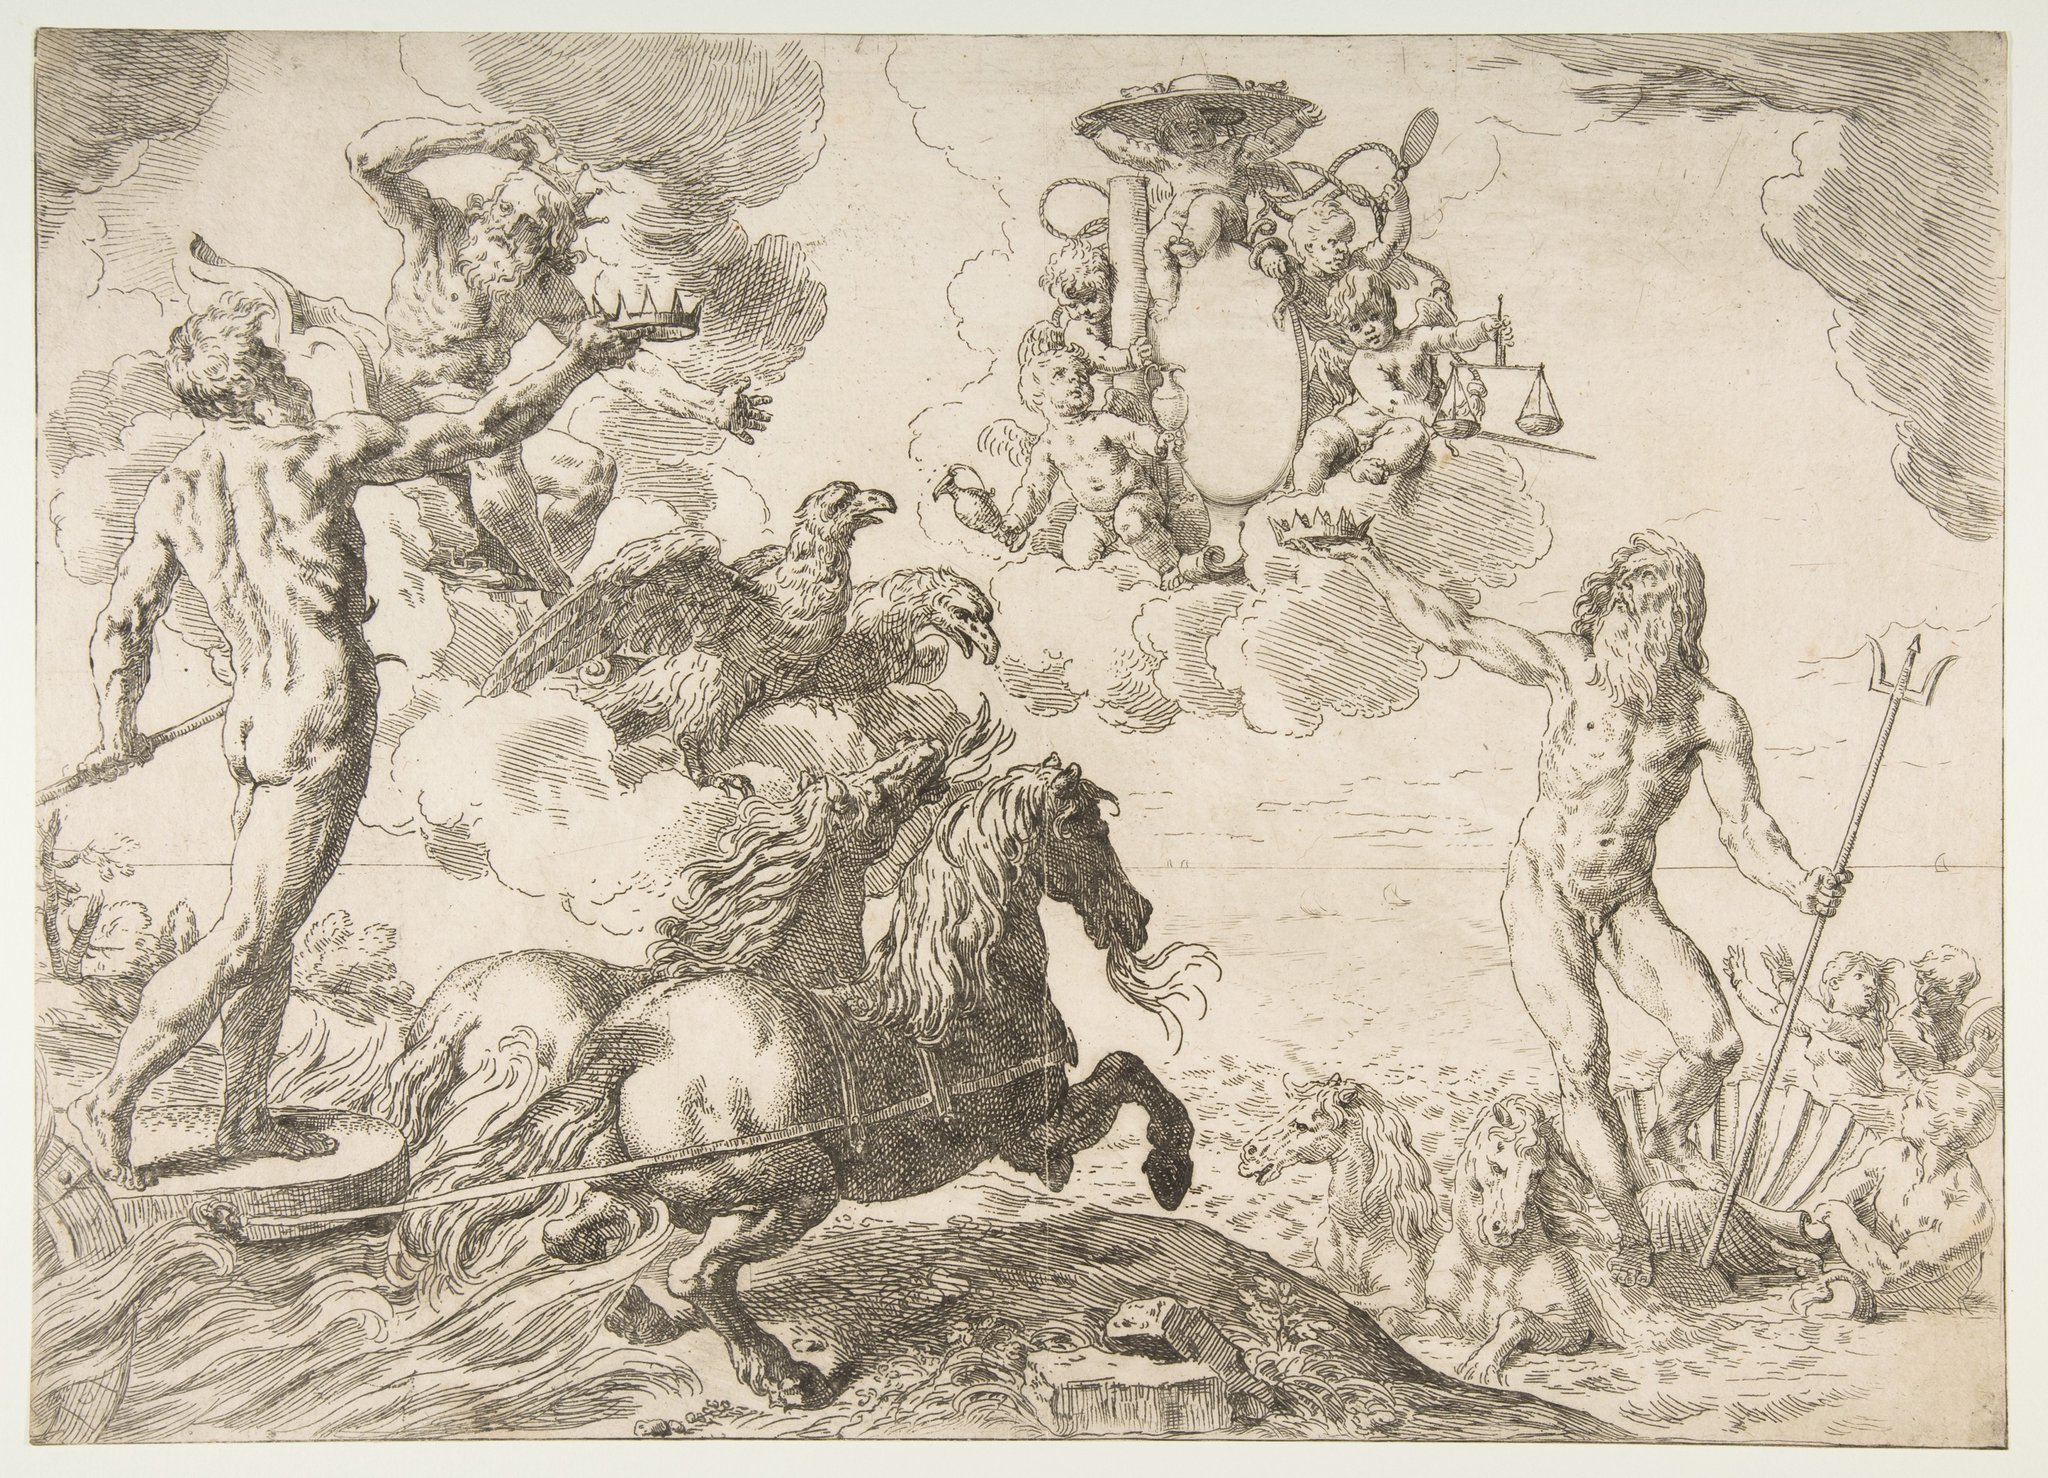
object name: print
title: Jupiter, Neptune, and Pluto offering their crowns to the arms of Cardinal Borghese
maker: simone cantarini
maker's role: artist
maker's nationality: italian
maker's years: 1612-1648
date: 1642-1643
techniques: etching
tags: male nudes,putti,jupiter,neptune,horses,pluto